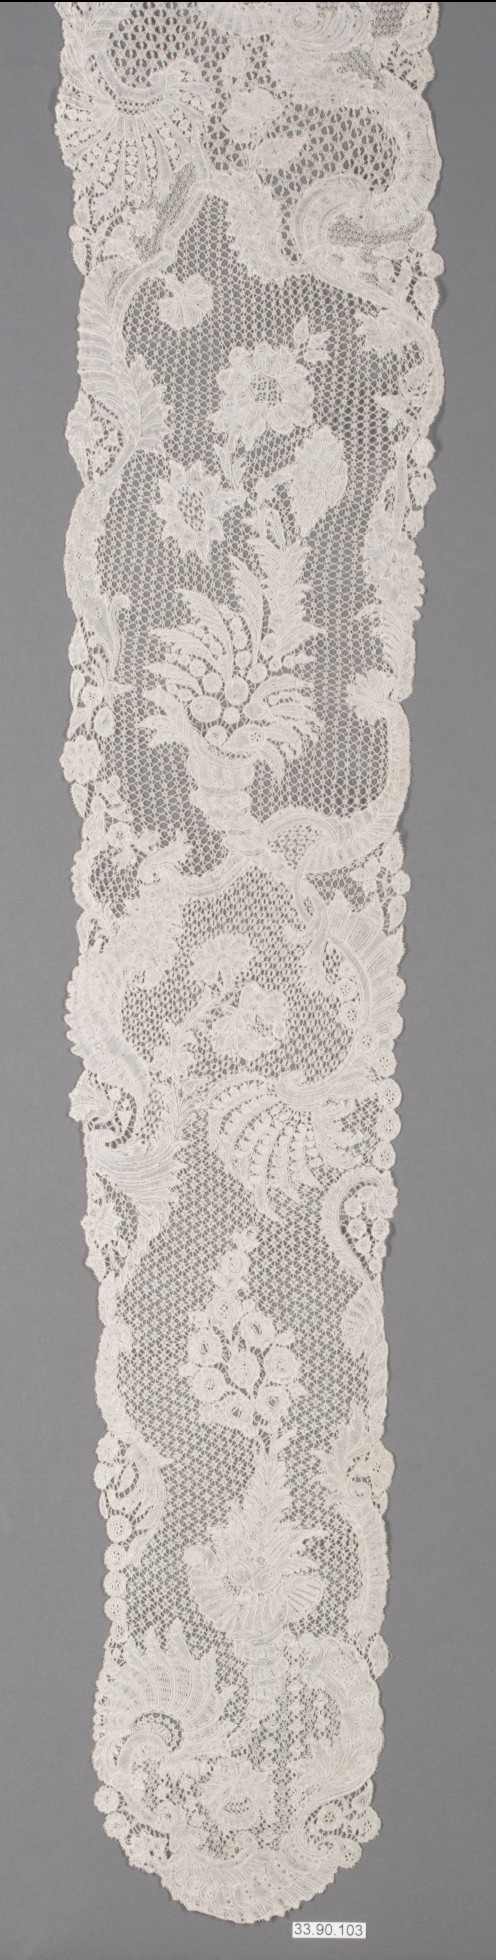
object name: lappet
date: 1734-1766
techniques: lace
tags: flowers